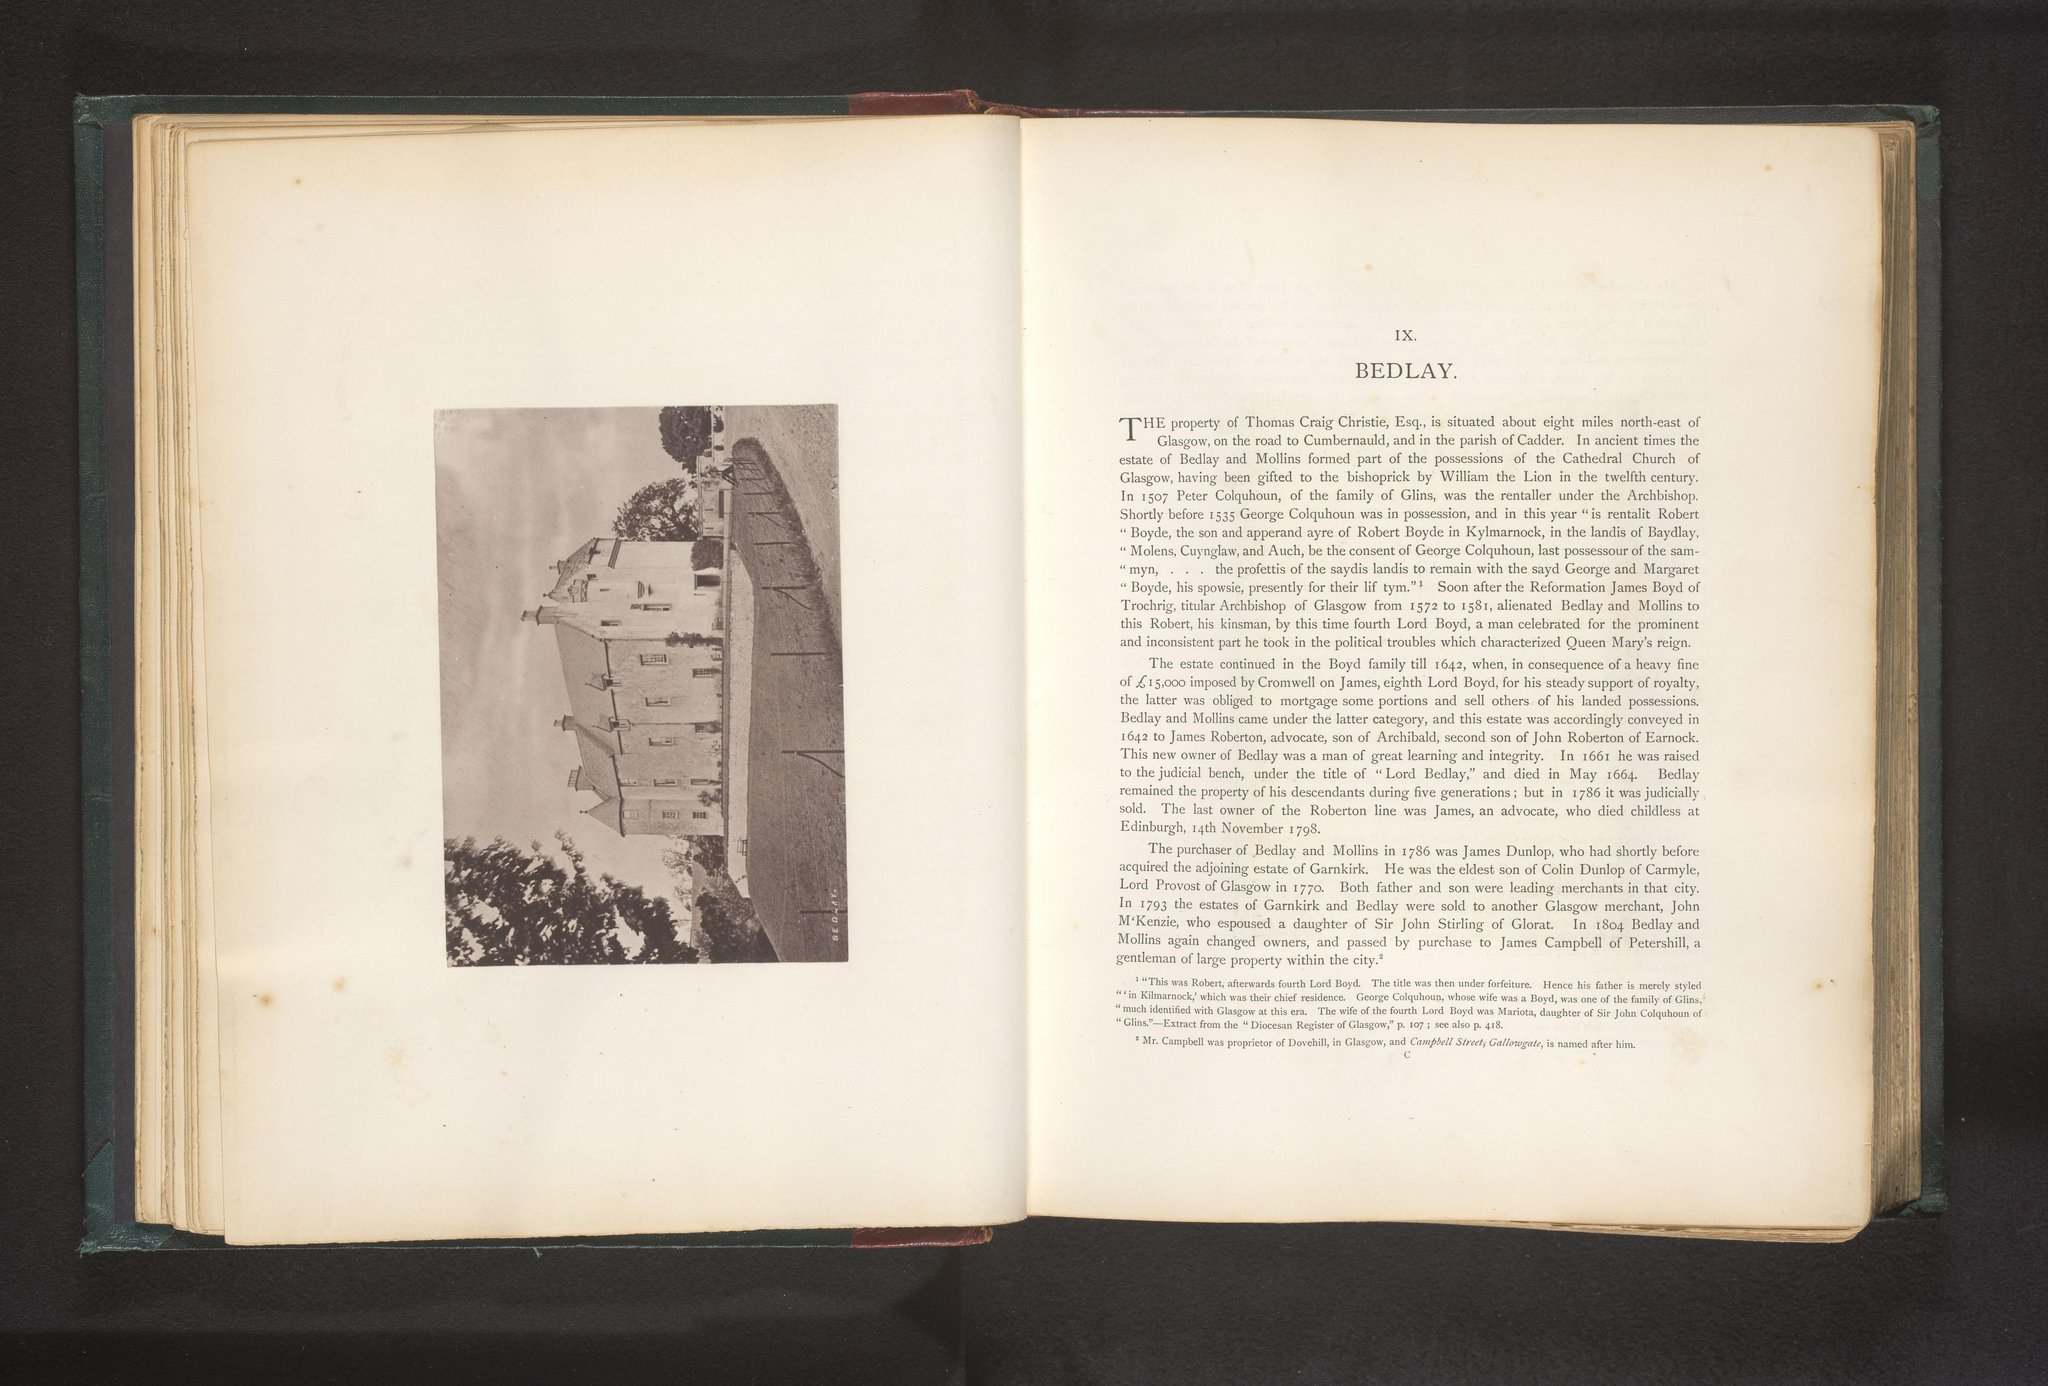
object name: page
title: Bedlay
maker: thomas annan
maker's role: fotograaf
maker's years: 1829-1887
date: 1868-1878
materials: paper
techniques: carbon print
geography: lanarkshire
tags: castle, façade (of house or building)